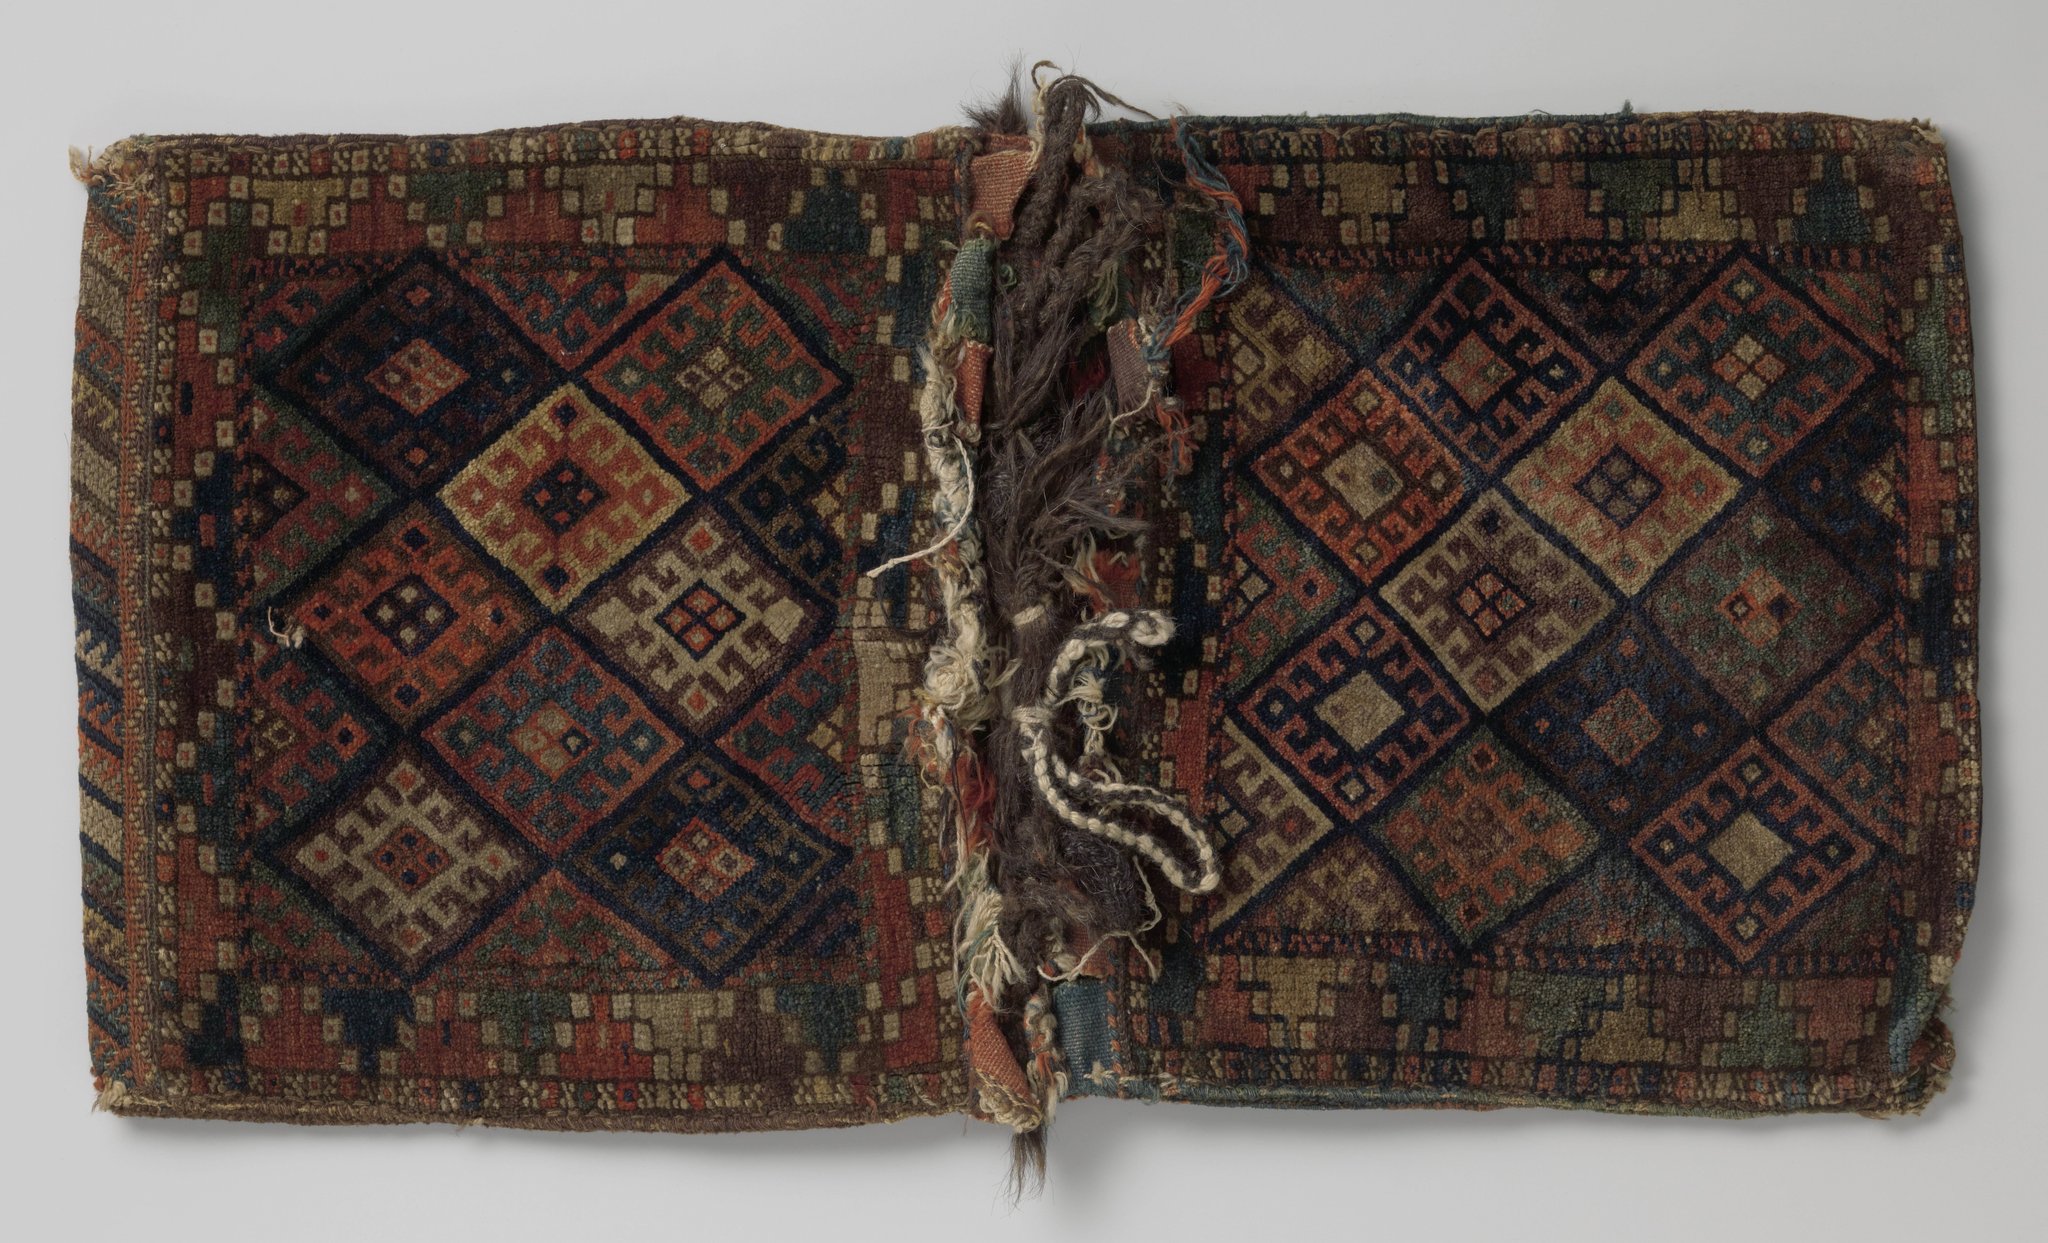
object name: zadeltas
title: Zadeltas, dubbel, versierd met rasterwerk waarbinnen hakenkruisbloemen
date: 1800-1975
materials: wool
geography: kurdistan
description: Dubbele zadeltas van geknoopte wol, Jaffi Kurdistan, vroeger Mosul. De voorzijden zijn door een raster in grote ruiten verdeeld, waarop telkens een kruisbloem met haken staat. Randen met een blokjeszigzaglijn. Geborduurde en in spleten gedeelde baarden in vlakweefsel, bedoeld als sluiting met de tegenover aangebrachte lange lussen van gevlochten geitenhaar. Achterkant van vlak weefsel met brede strepen.